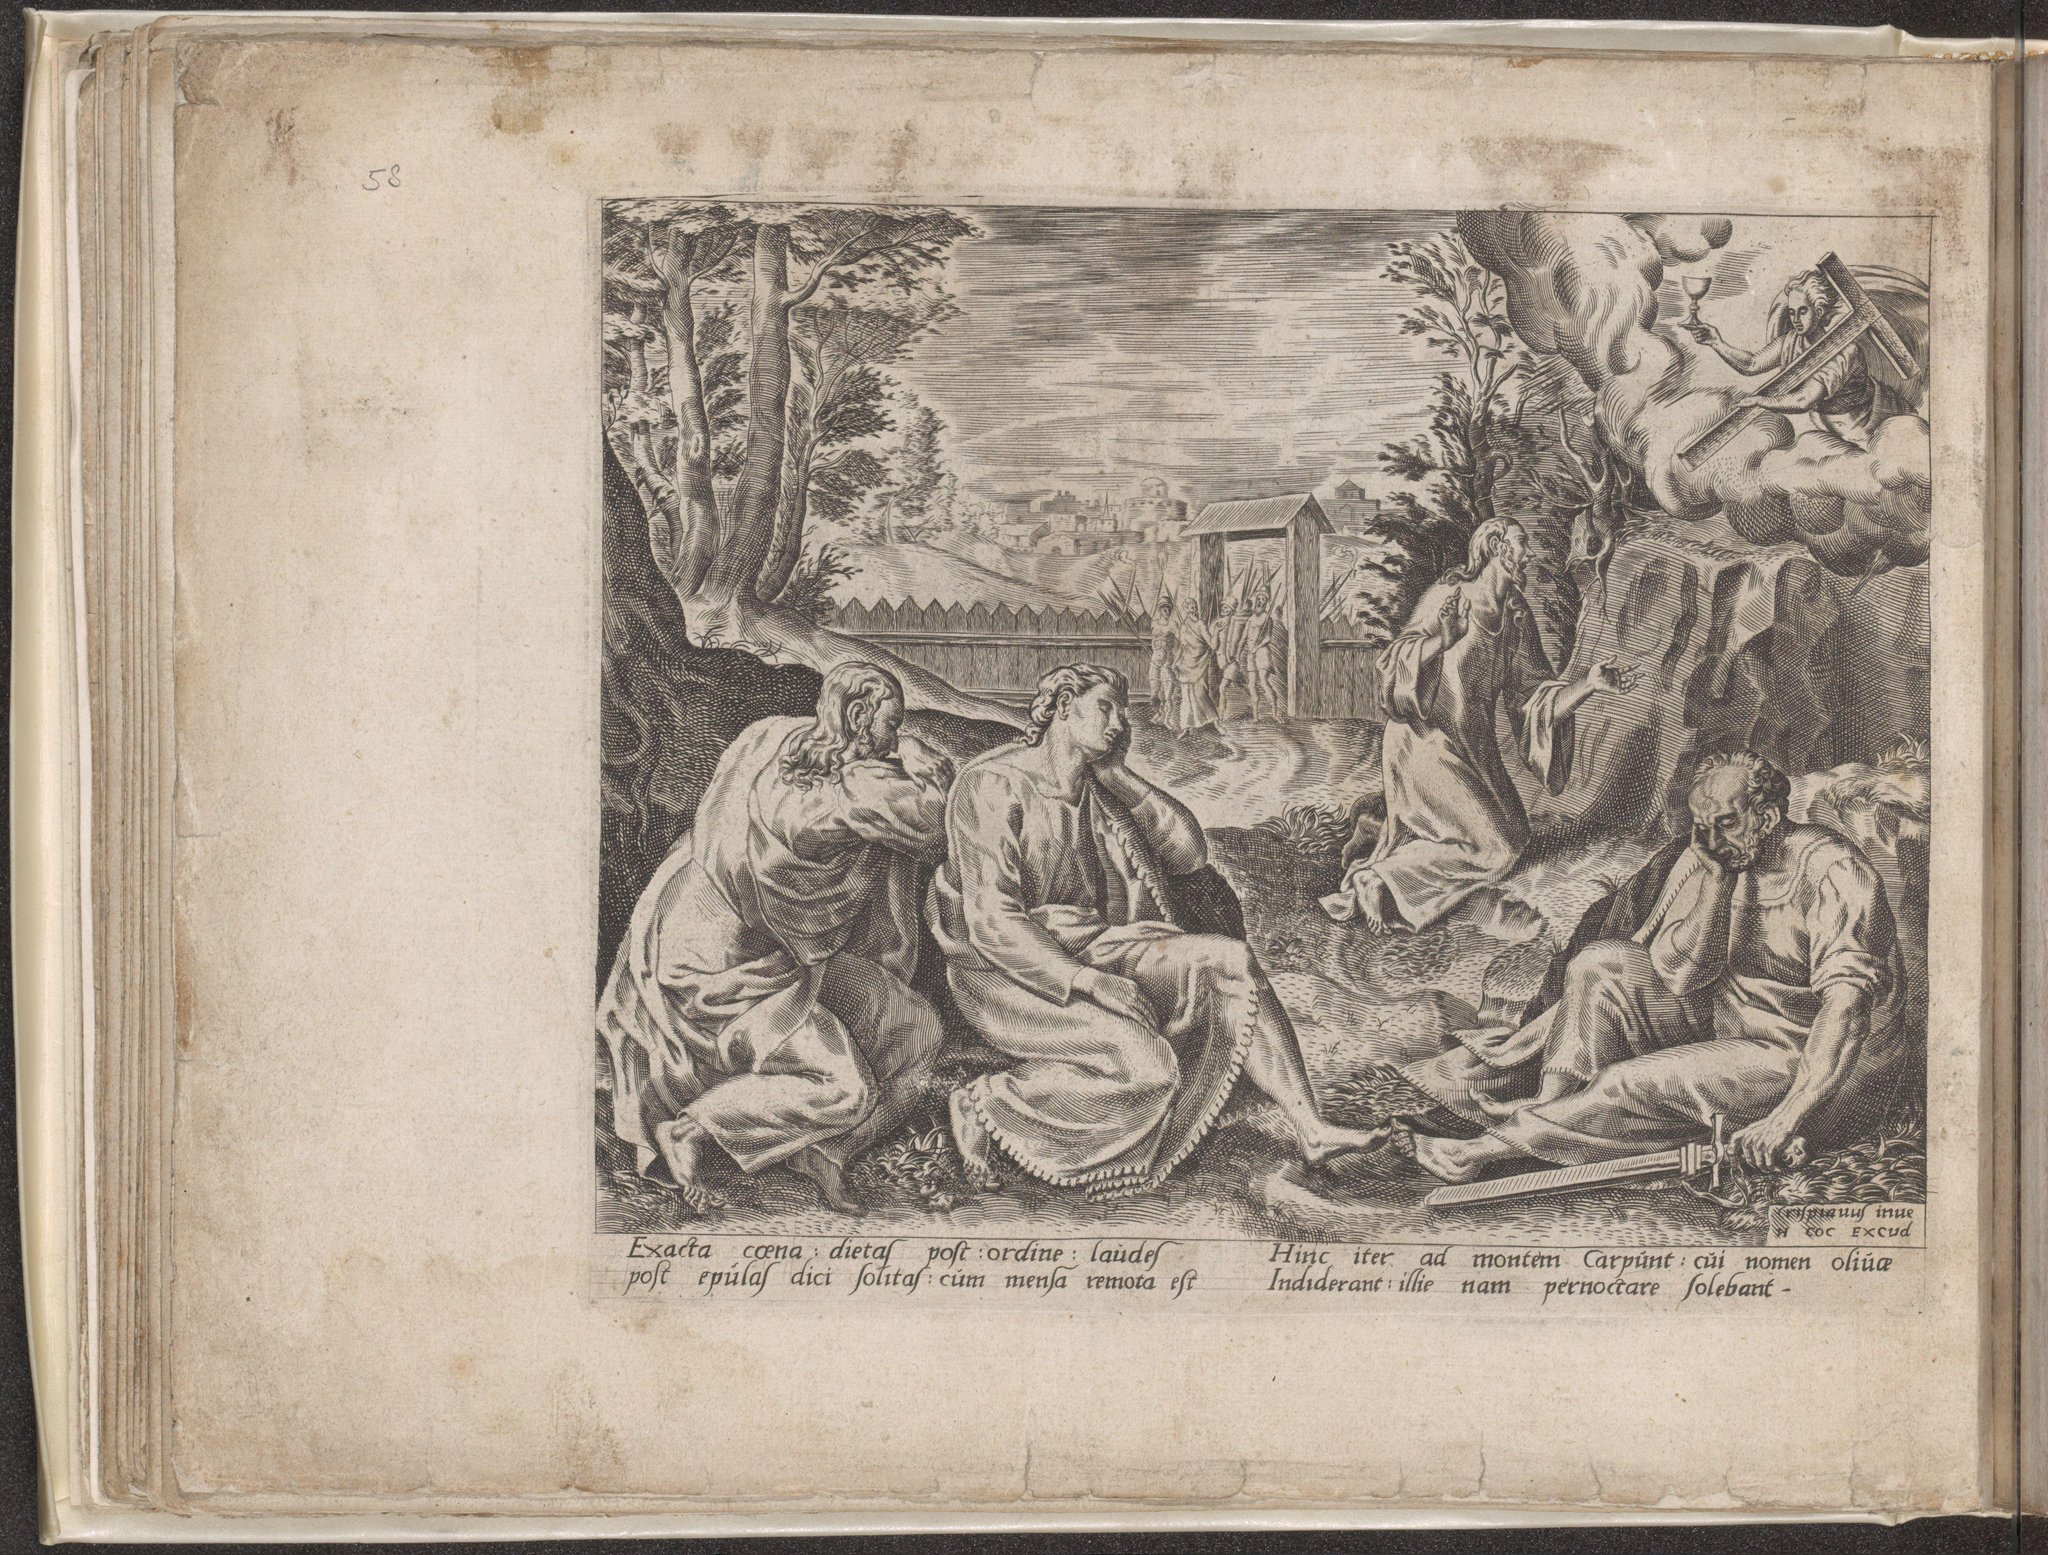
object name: album leaf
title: Christus in de hof van Getsemane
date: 1563-1567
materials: paper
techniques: engraving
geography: antwerp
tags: agony of christ; three (or eleven) apostles sleeping, christ's prayer in the garden of gethsemane during the night, agony of christ: to comfort him one or more angels appear to christ with chalice and/or cross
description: Christus bidt in de hof van Getsemane en vraagt aan God of deze beker aan hem voorbij mag gaan. In een wolk verschijnt een engel met een beker en een kruis. Op de voorgrond slapen Petrus, Johannes en Jacobus. Op de achtergrond leidt Judas een groep soldaten door de poort naar binnen. Onder de voorstelling een verklarende tekst in het Latijn. Deze prent maakt deel uit van een album.